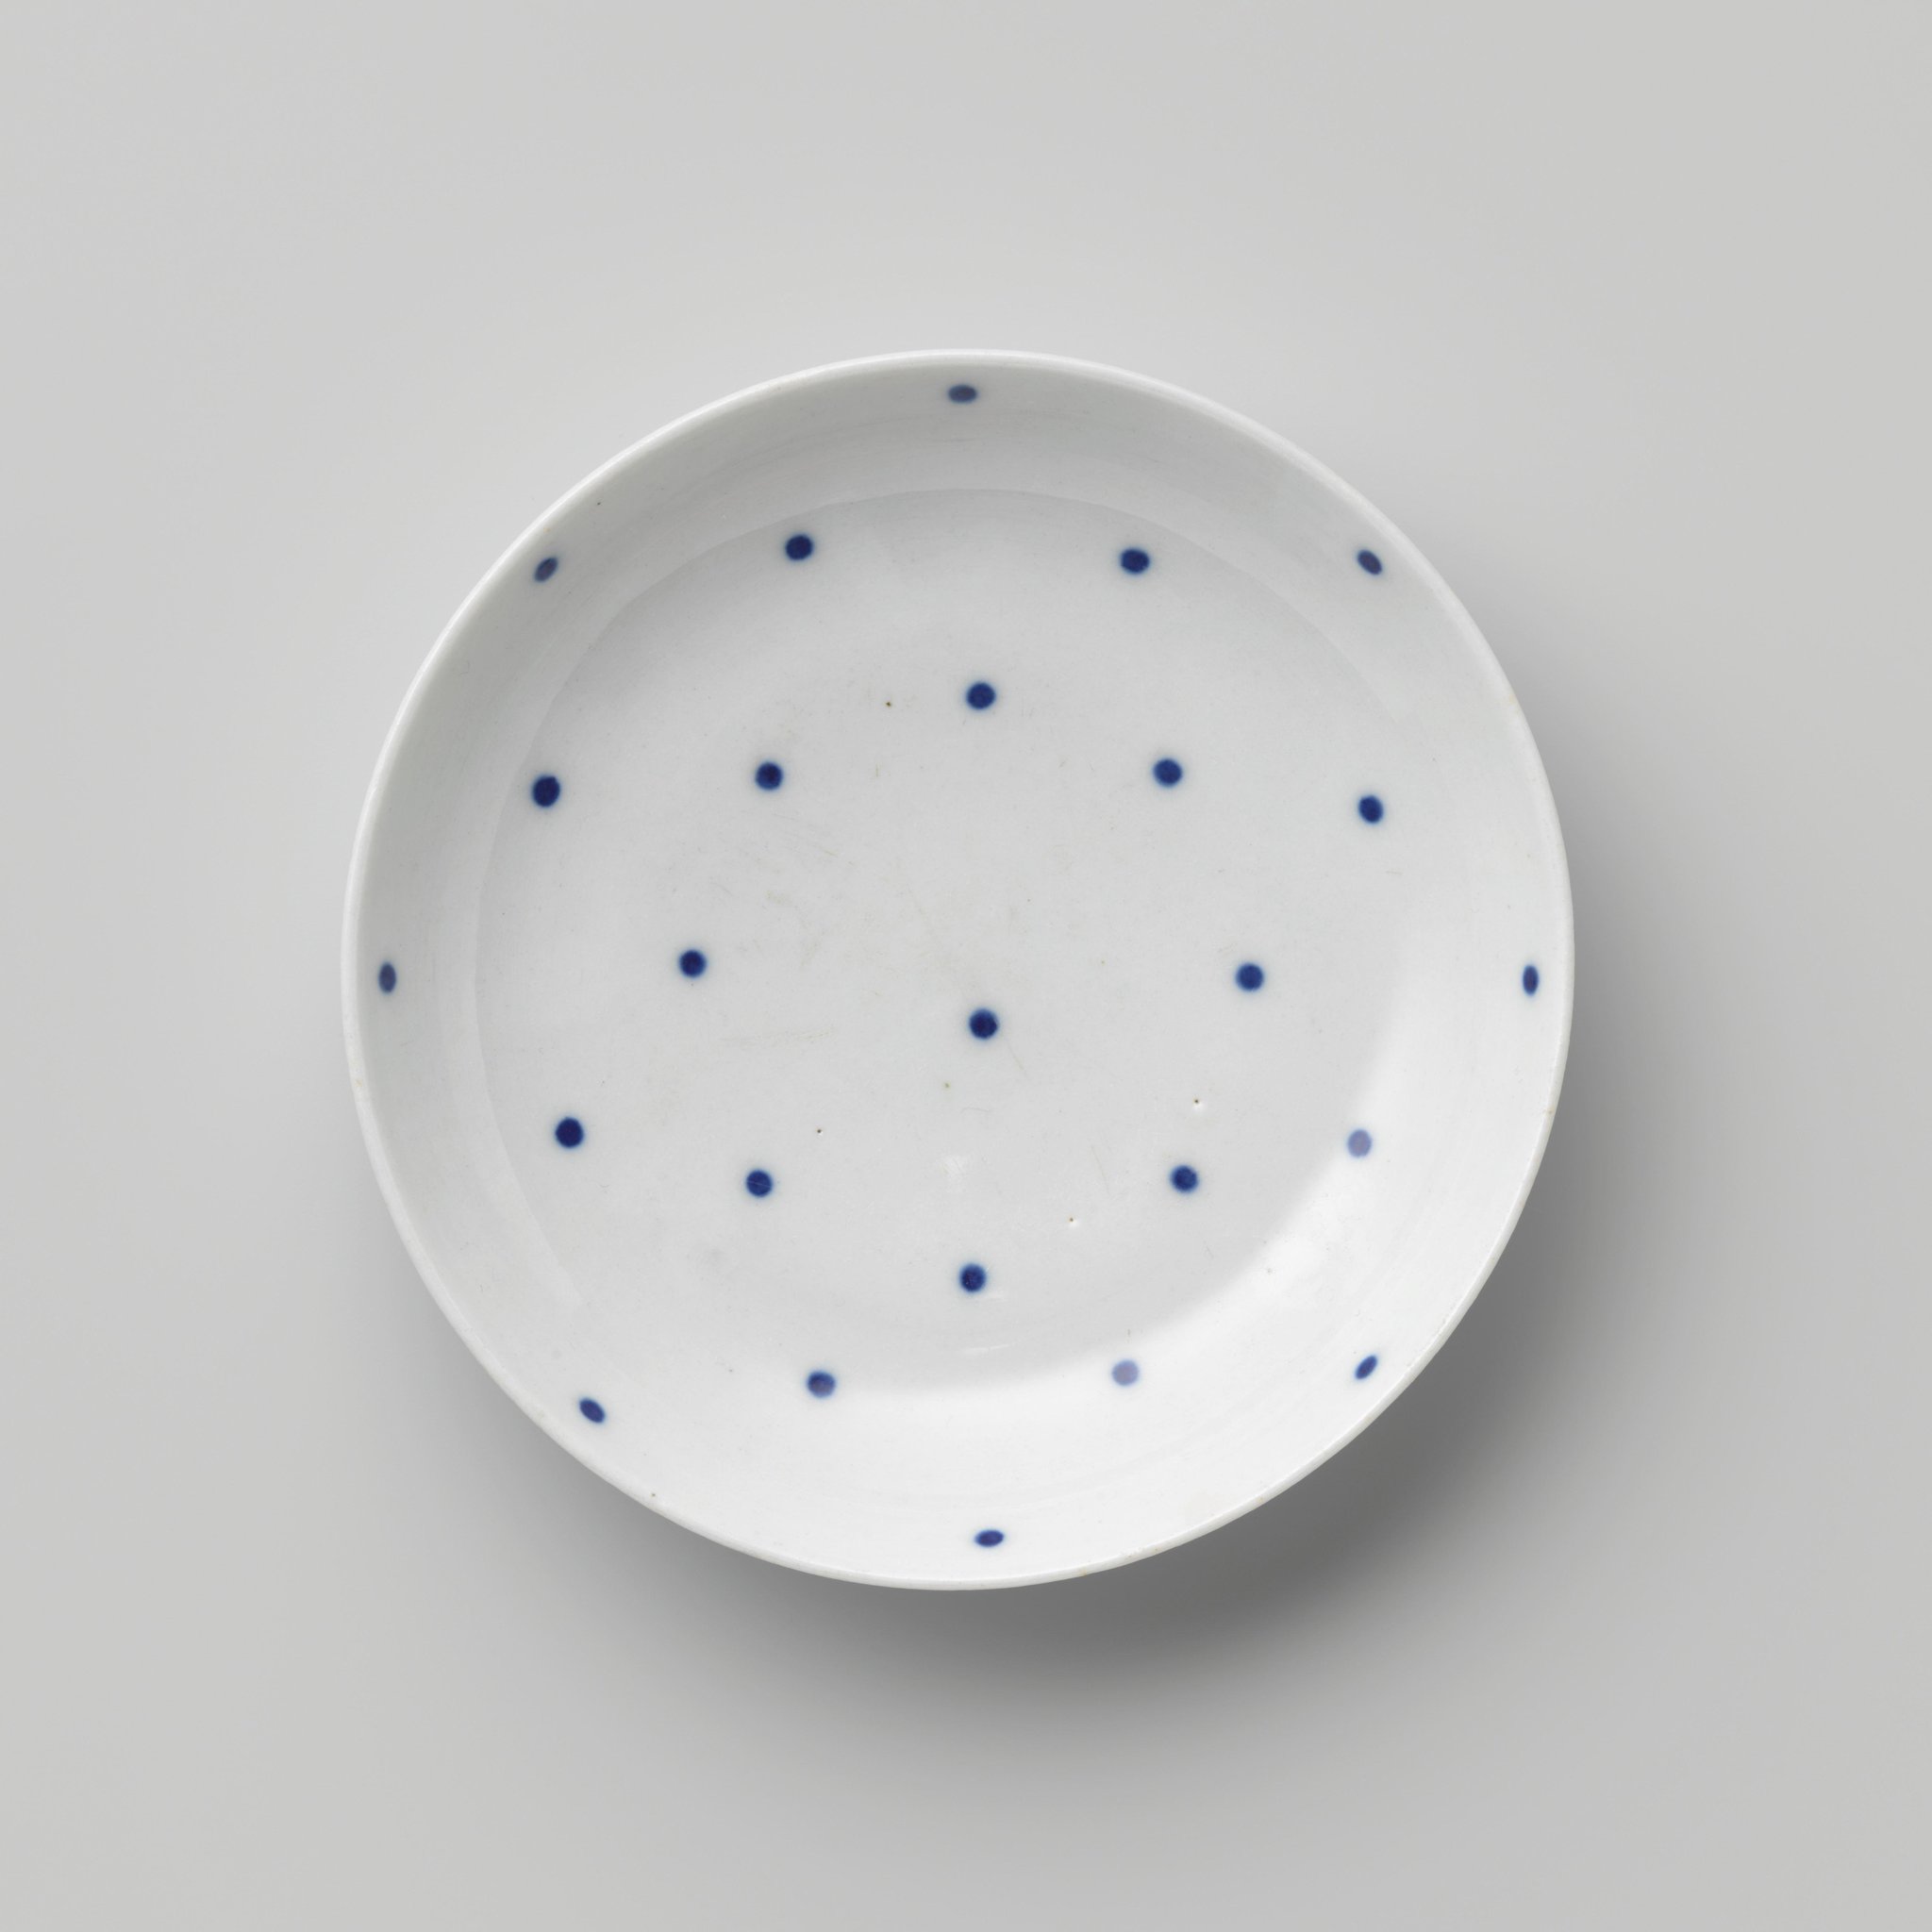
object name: platter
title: Schotel with blue dots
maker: Anonymous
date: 1775-1799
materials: cobalt, glaze, paint, porcelain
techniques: firing, turning, vitrification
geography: europe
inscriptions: mark: ‘3’, mark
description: Schotel van porselein, beschilderd in onderglazuur blauw. Het plat is versierd met stippen. Gemerkt op de onderzijde met een teken en een 3.